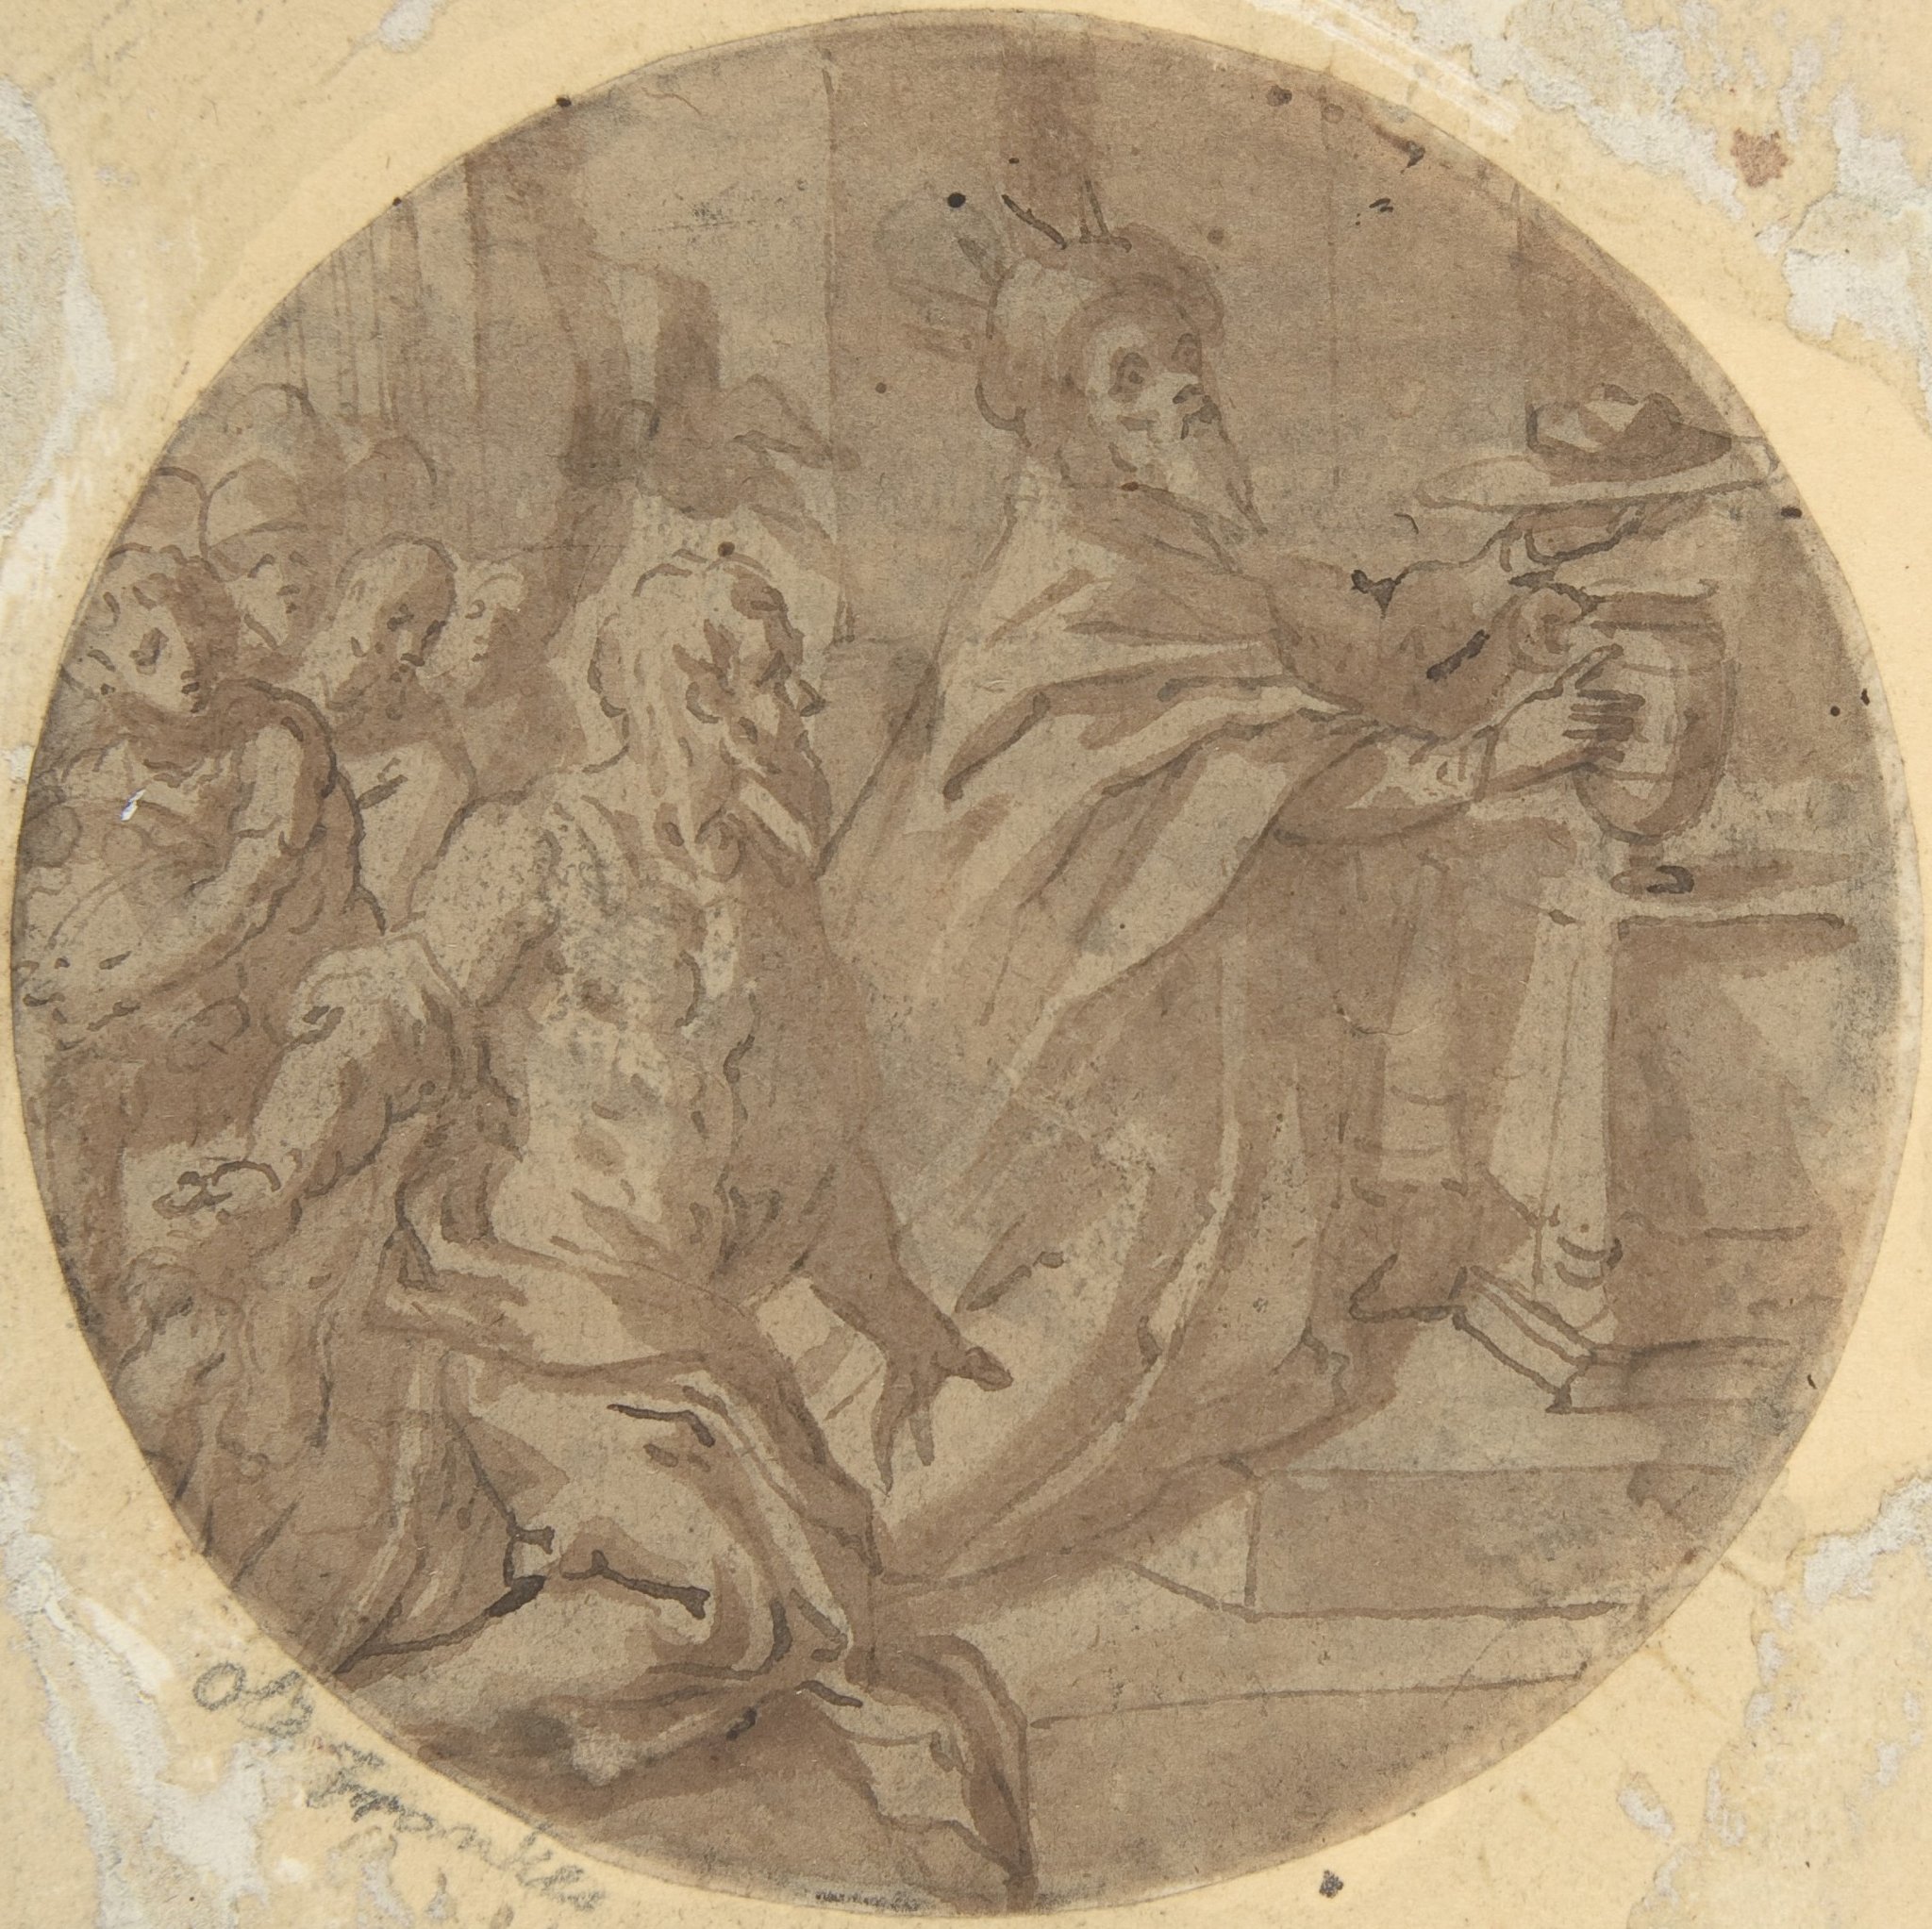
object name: drawing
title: Melchizedek Offering Bread and Wine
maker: anonymous, italian, 16th century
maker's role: artist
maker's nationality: italian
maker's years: 1550-1600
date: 1501-1600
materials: ink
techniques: pen, wash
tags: bread,wine,men